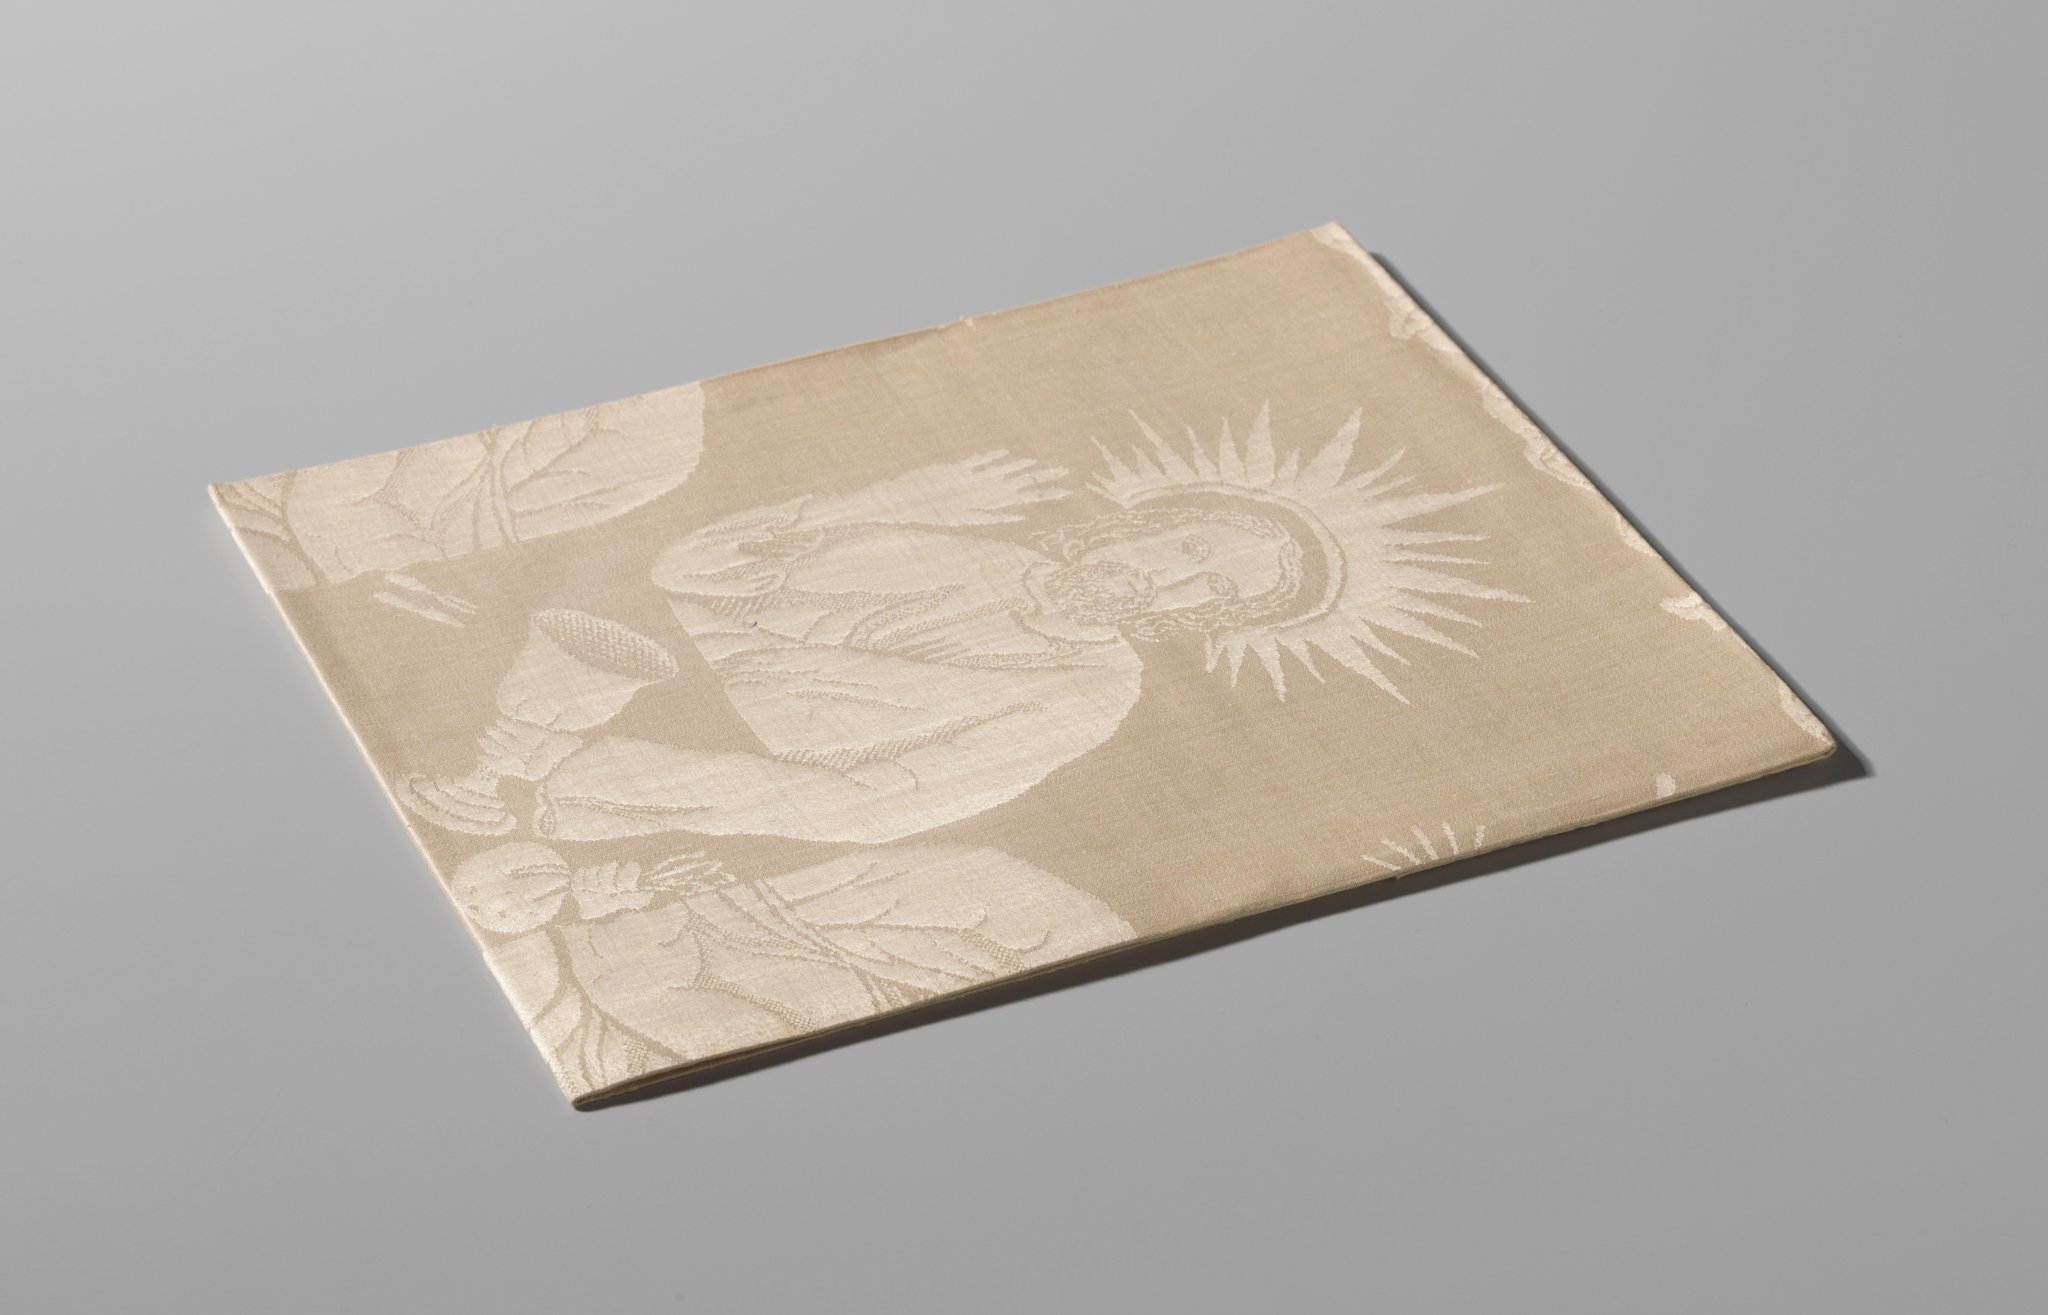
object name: napkin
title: Servet van wit linnendamast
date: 1859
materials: linen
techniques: damask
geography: borne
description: Wit linnen damasten servet met een voorstelling van het Laatste Avondmaal.